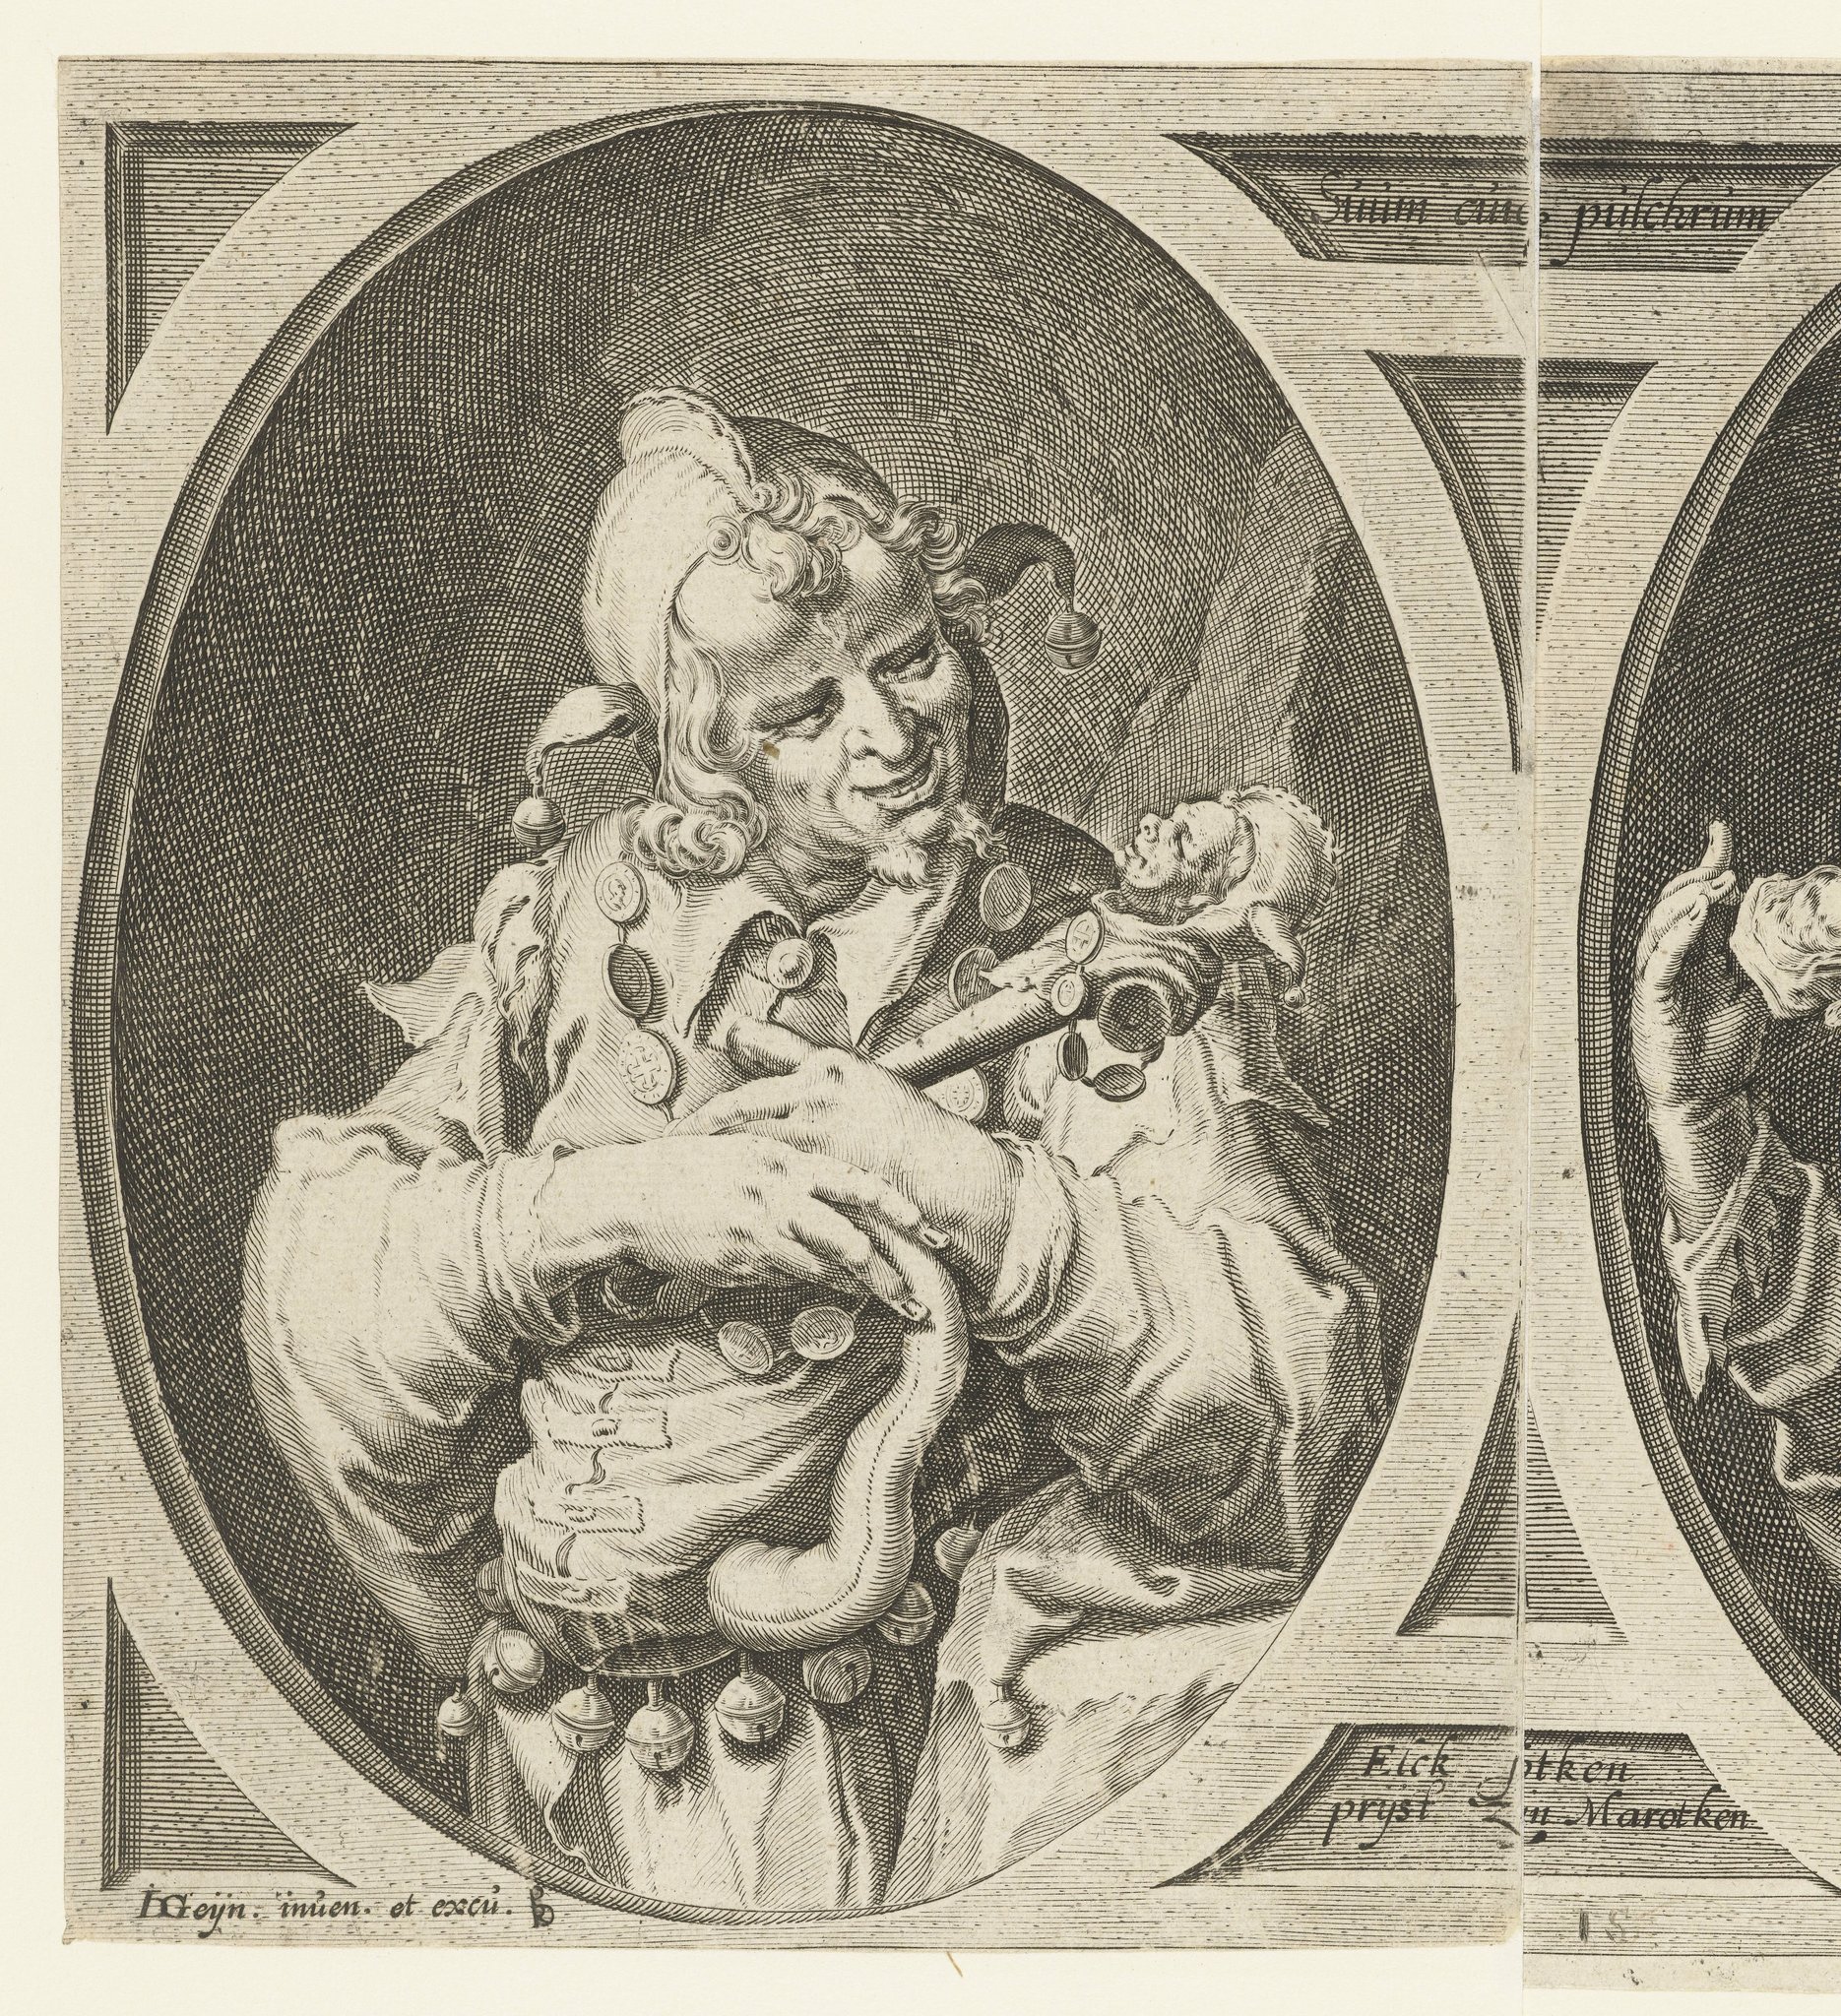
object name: print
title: Nar met narrenkap op het hoofd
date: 1596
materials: paper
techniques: engraving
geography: netherlands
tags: court jester, court fool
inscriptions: inscription: ‘Elck sotken prijst zijn marotken’, collector's mark: Lugt 2228a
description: Een nar, ten halven lijve, in ovaalvormige omlijsting, met een narrenkap op het hoofd en een marot (knots met aan het uiteinde een buste van zichzelf) in de handen. Dit object is het linkerdeel van een in tweeën geknipte prent van twee narren in ovale omlijstingen, met tussen de ovalen een Lartijns opschrift en de Nederlandse vertaling daarvan.